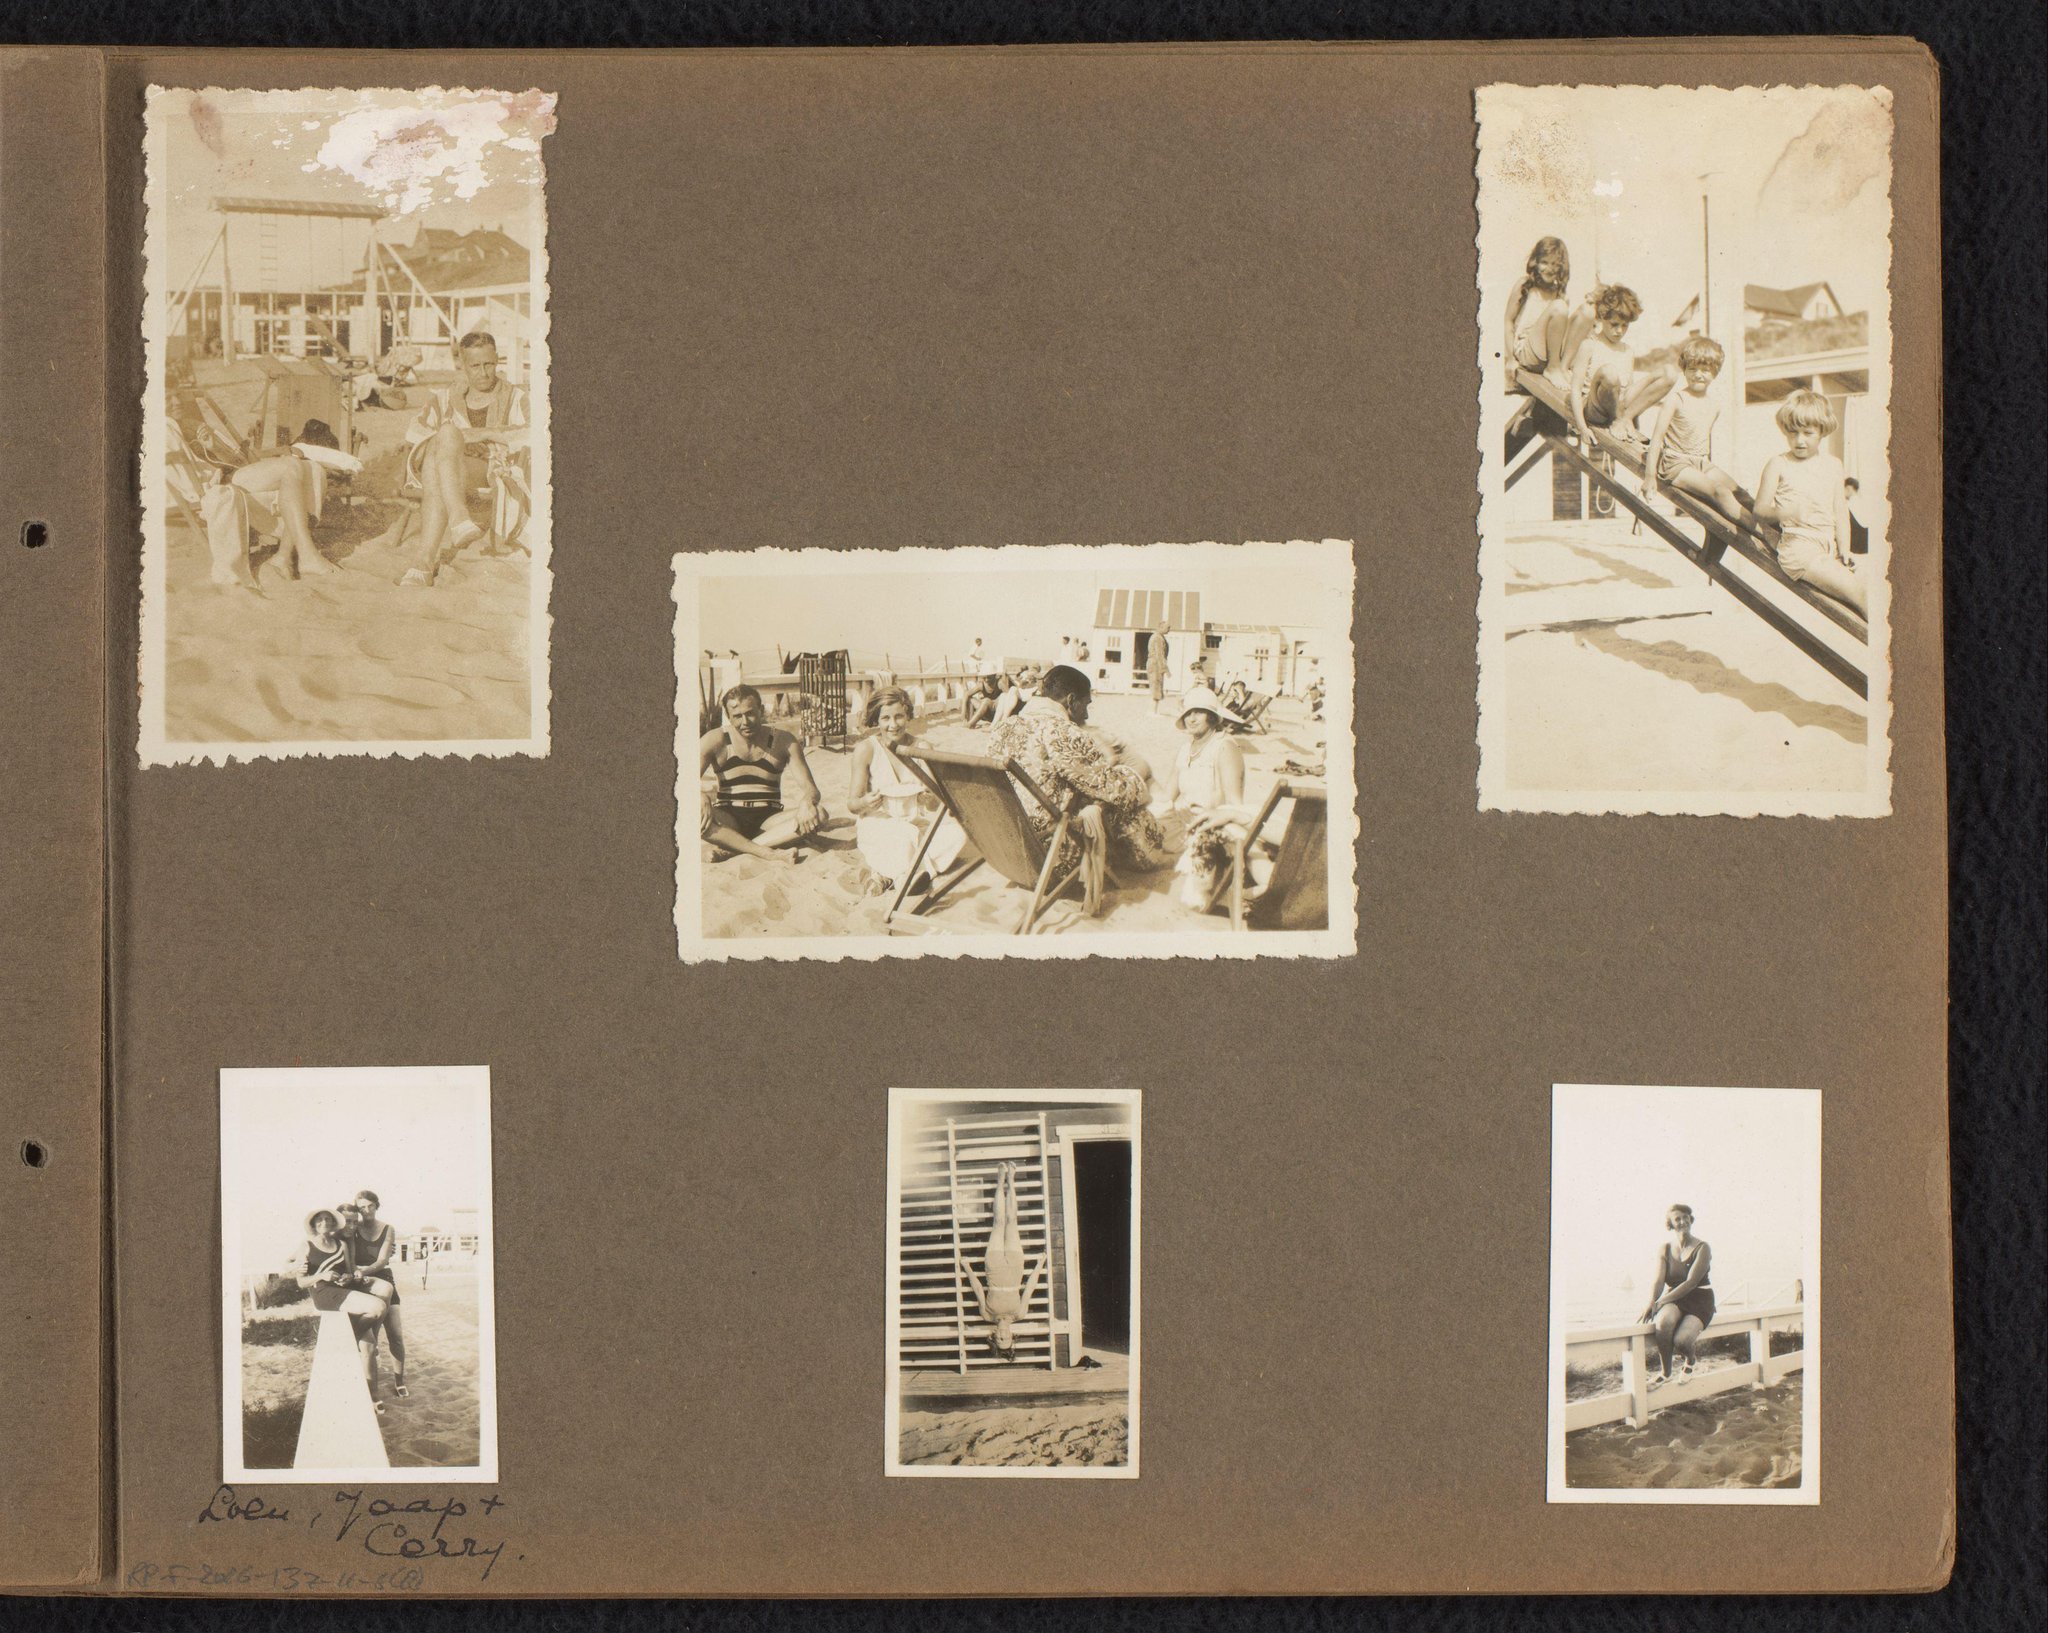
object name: album leaf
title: Loentje Furnée met vrienden en kinderen op het strand van Noordwijk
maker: carolina frederika onnen (lien/loen)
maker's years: 1896-1983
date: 1930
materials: paper, cardboard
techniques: gelatin silver print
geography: noordwijk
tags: carolina frederika onnen (lien/loen), beach (as place of recreation)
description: Deze foto's zijn onderdeel van een album.